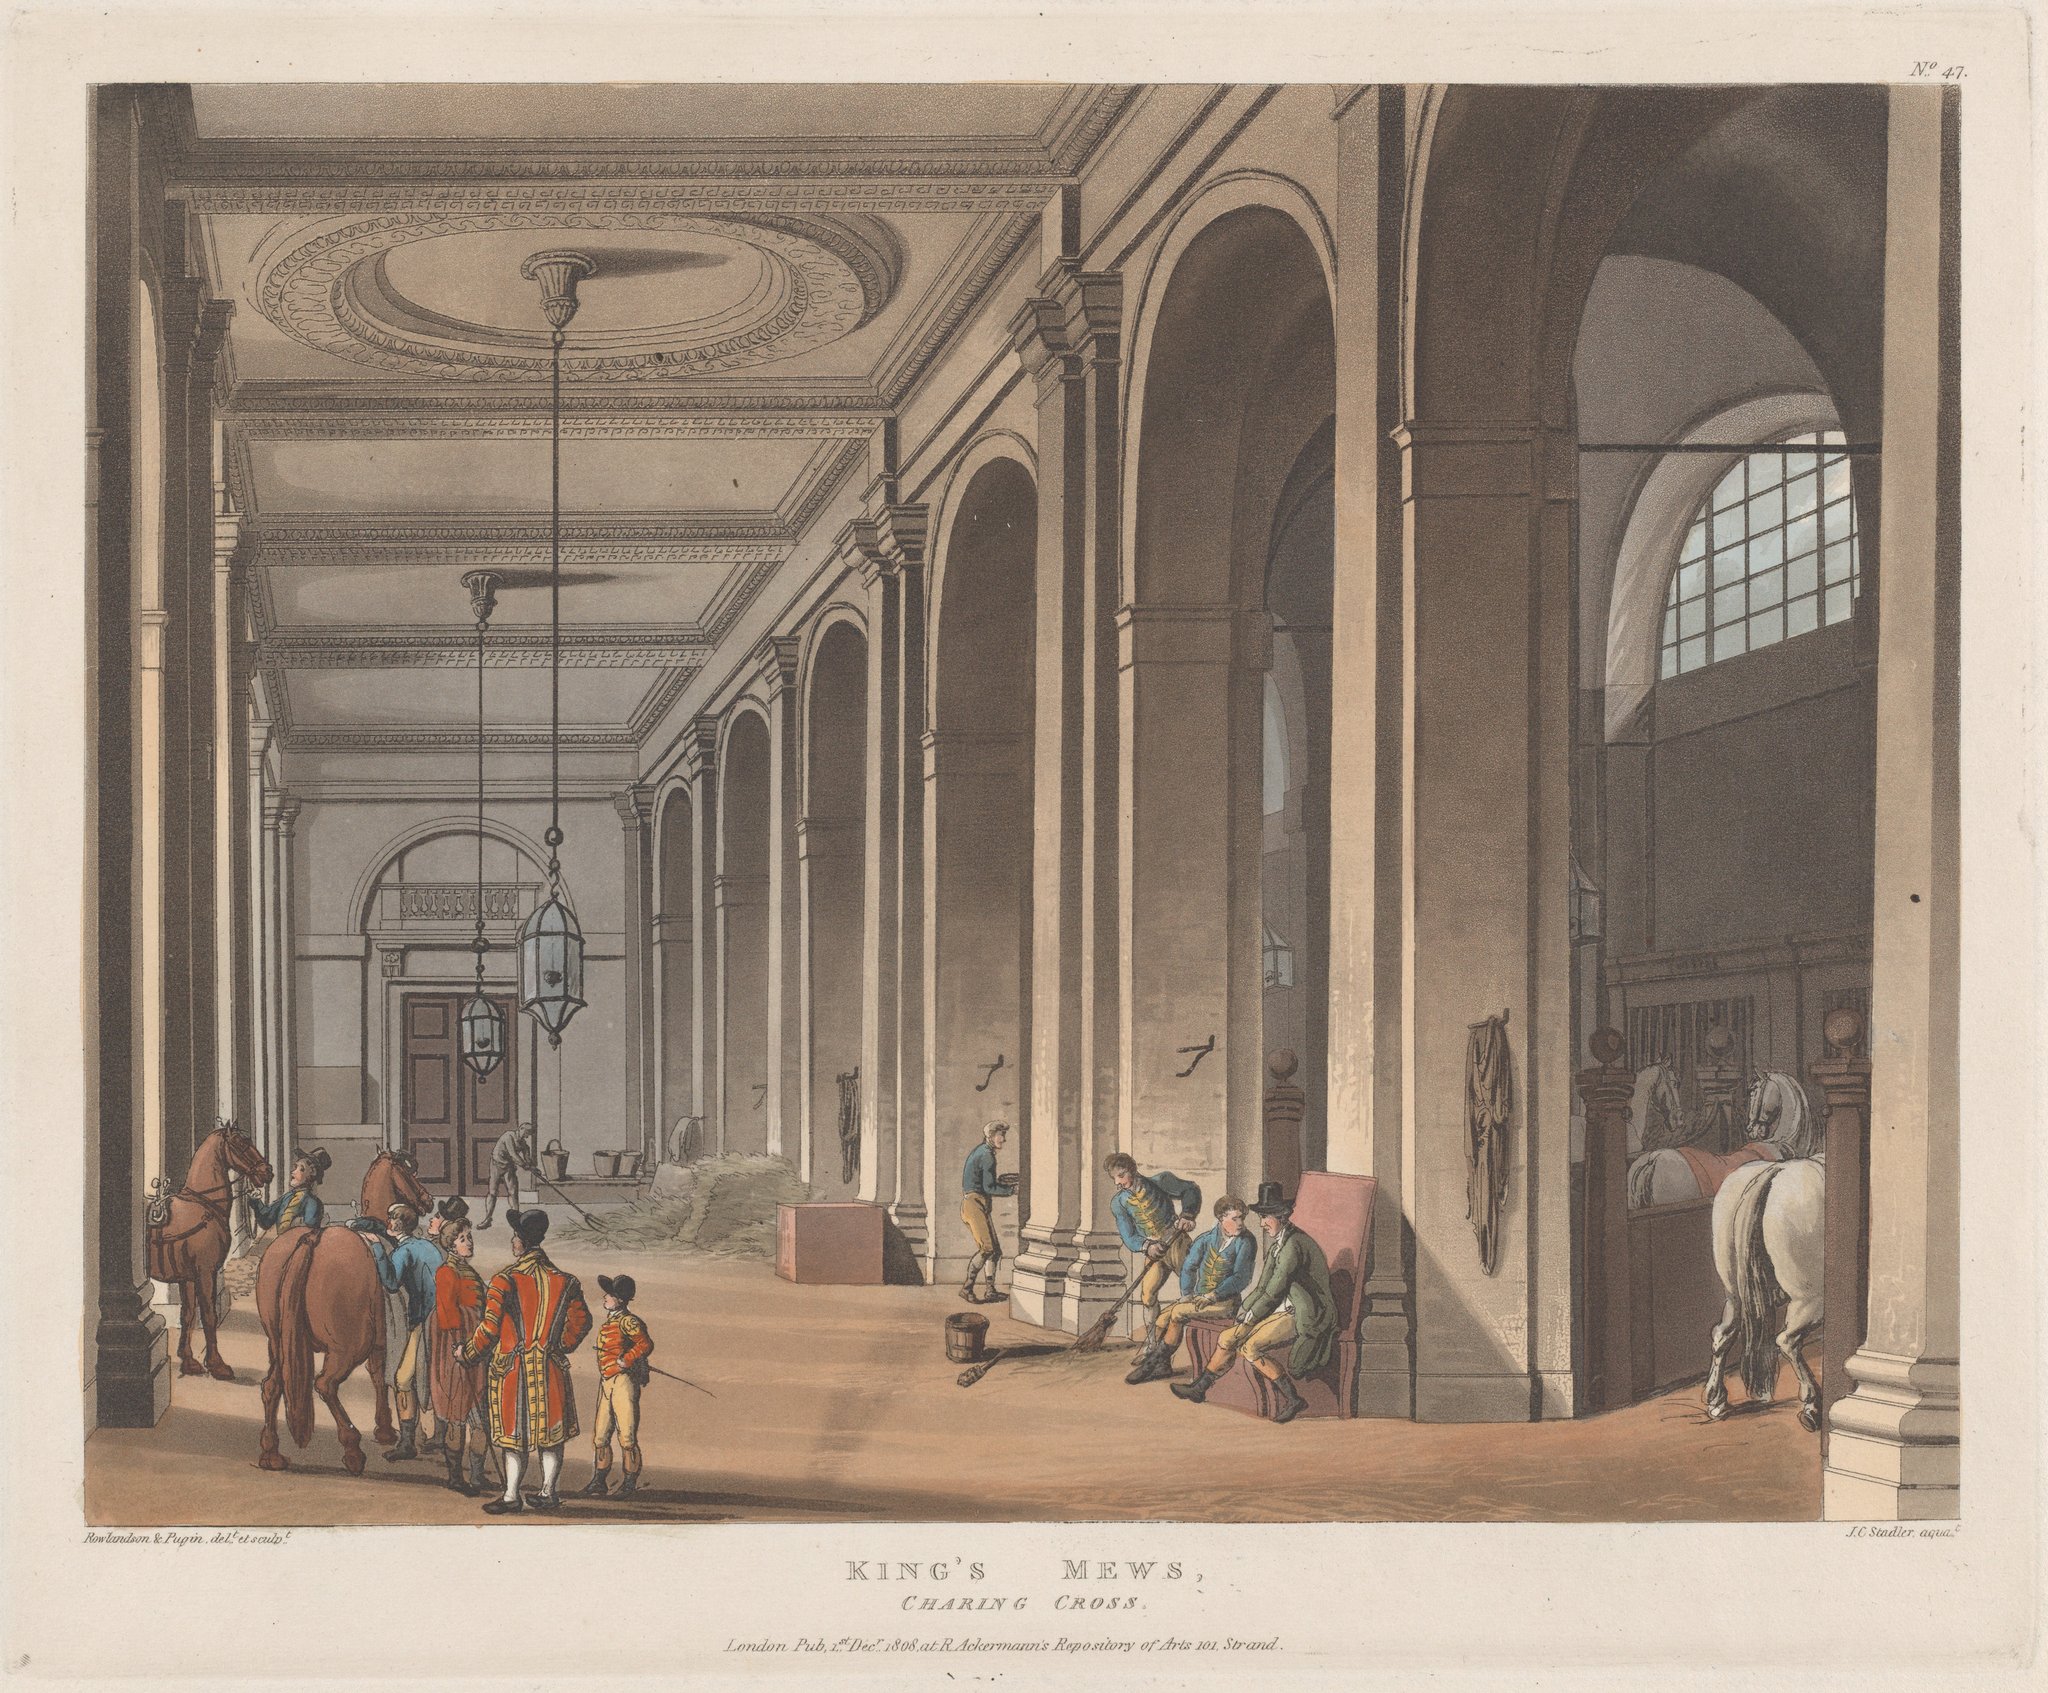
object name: print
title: King's Mews, Charing Cross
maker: thomas rowlandson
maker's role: artist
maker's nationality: british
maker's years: 1757-1827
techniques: aquatint, etching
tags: interiors,horses